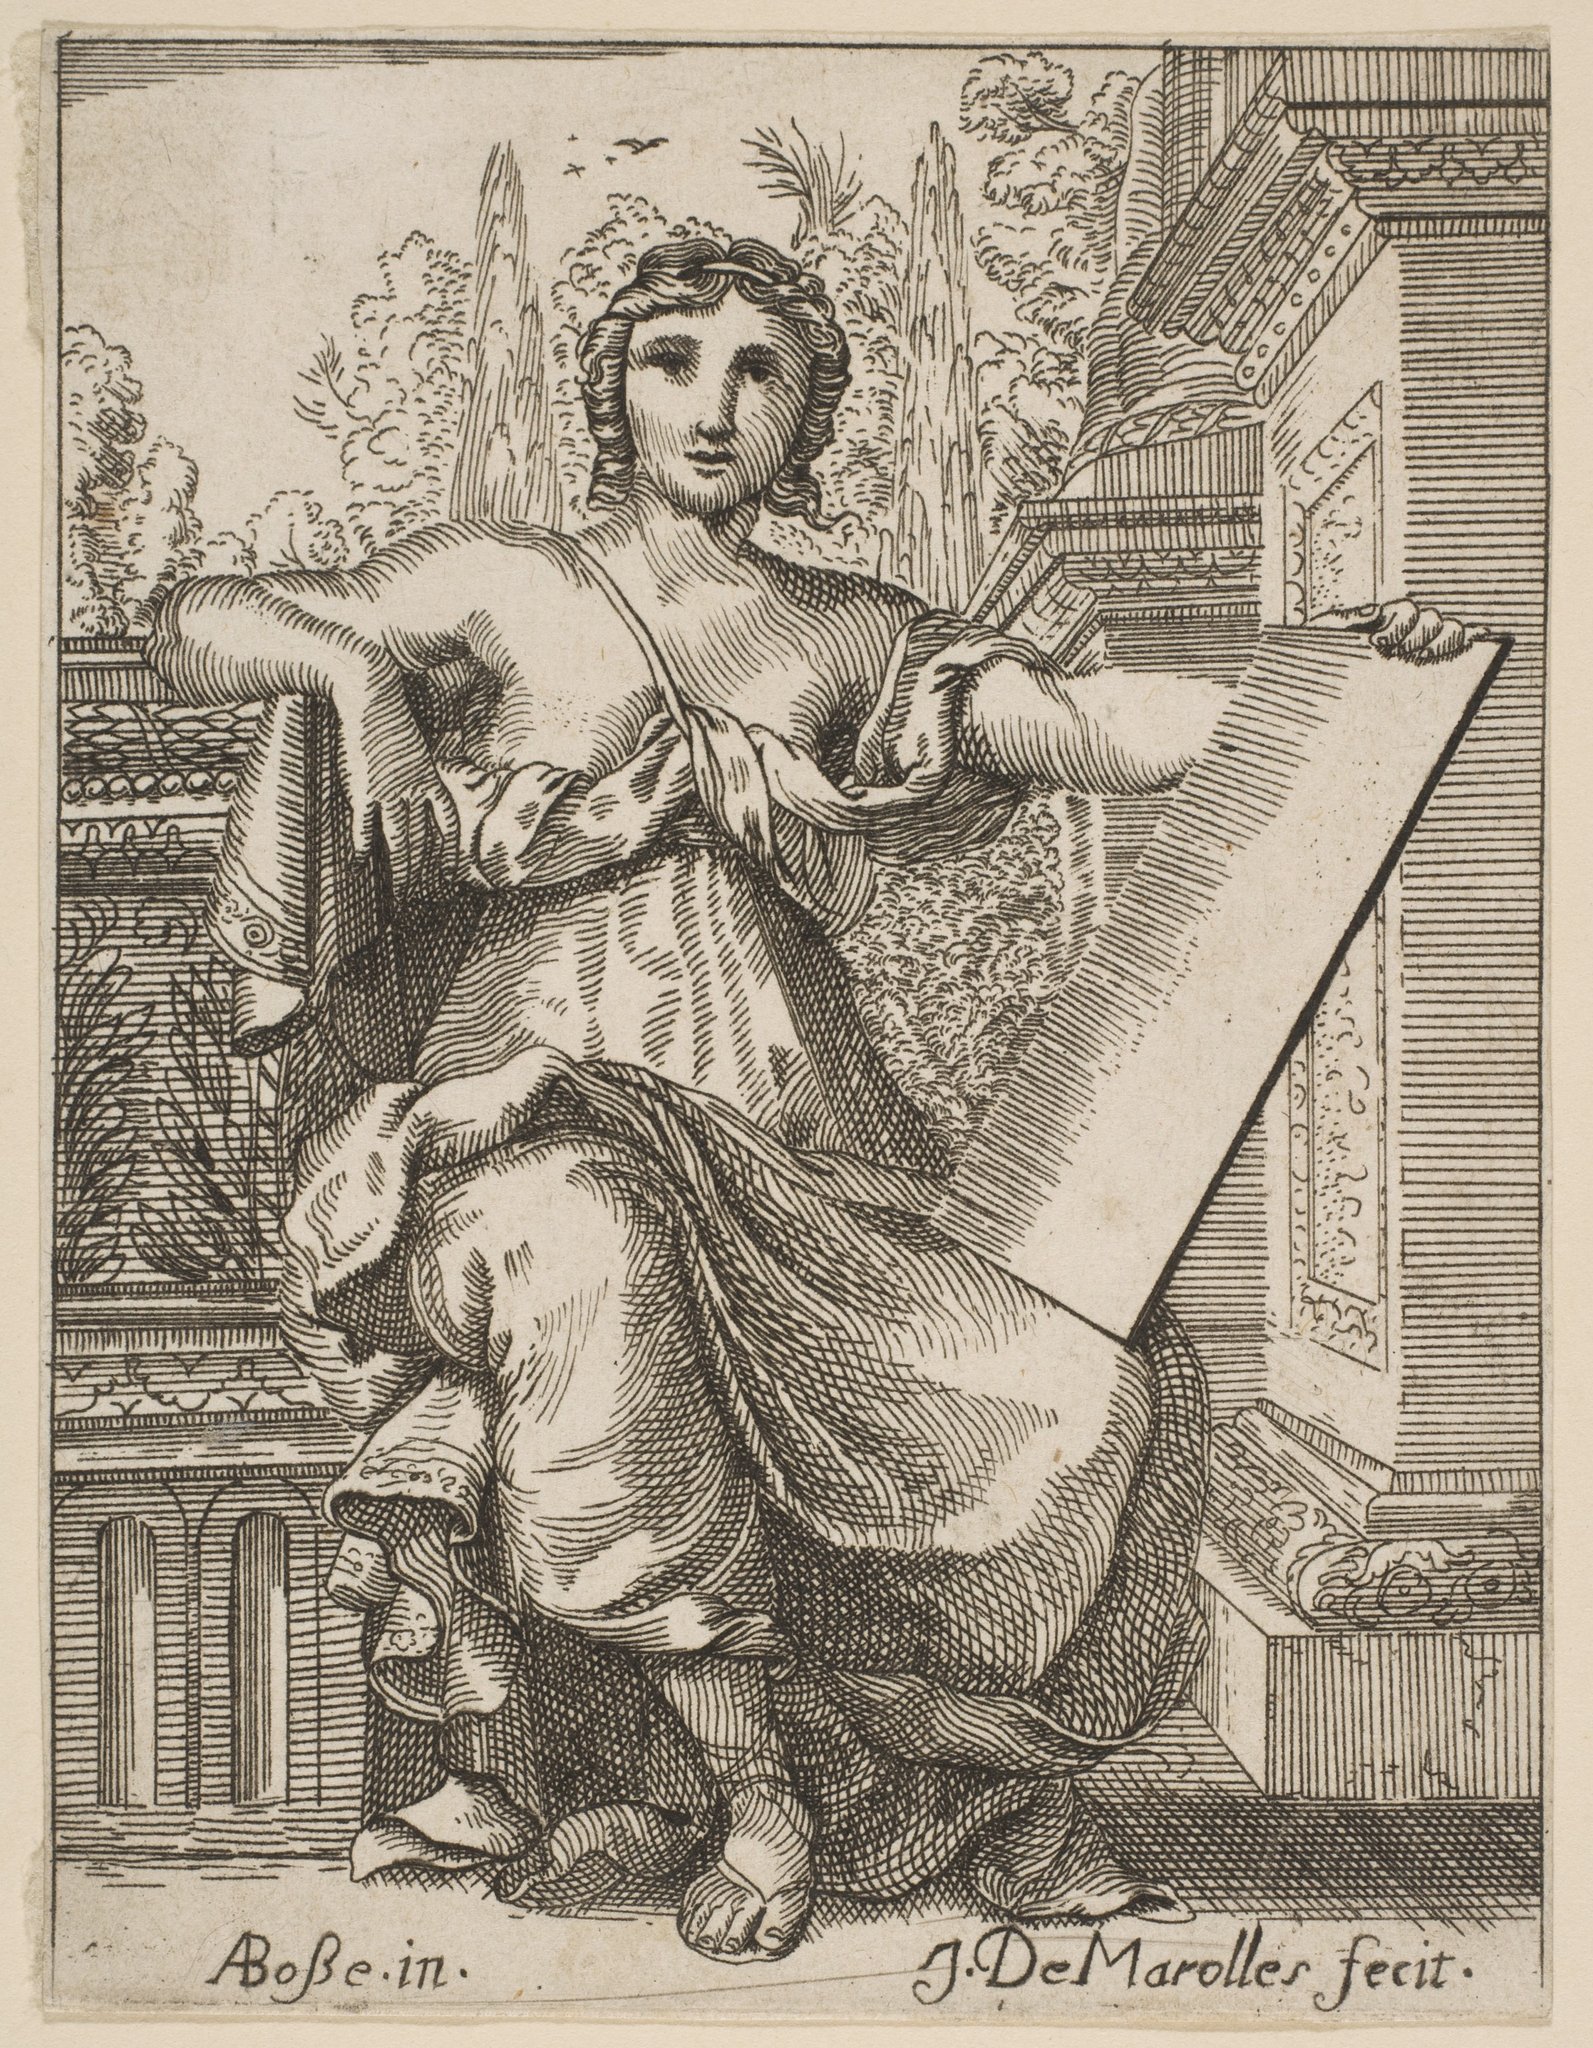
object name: print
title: Seated Woman Holding a Tablet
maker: jean antoine de maroulles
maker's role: artist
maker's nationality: italian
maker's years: 1674-1726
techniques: etching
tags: tablets,women